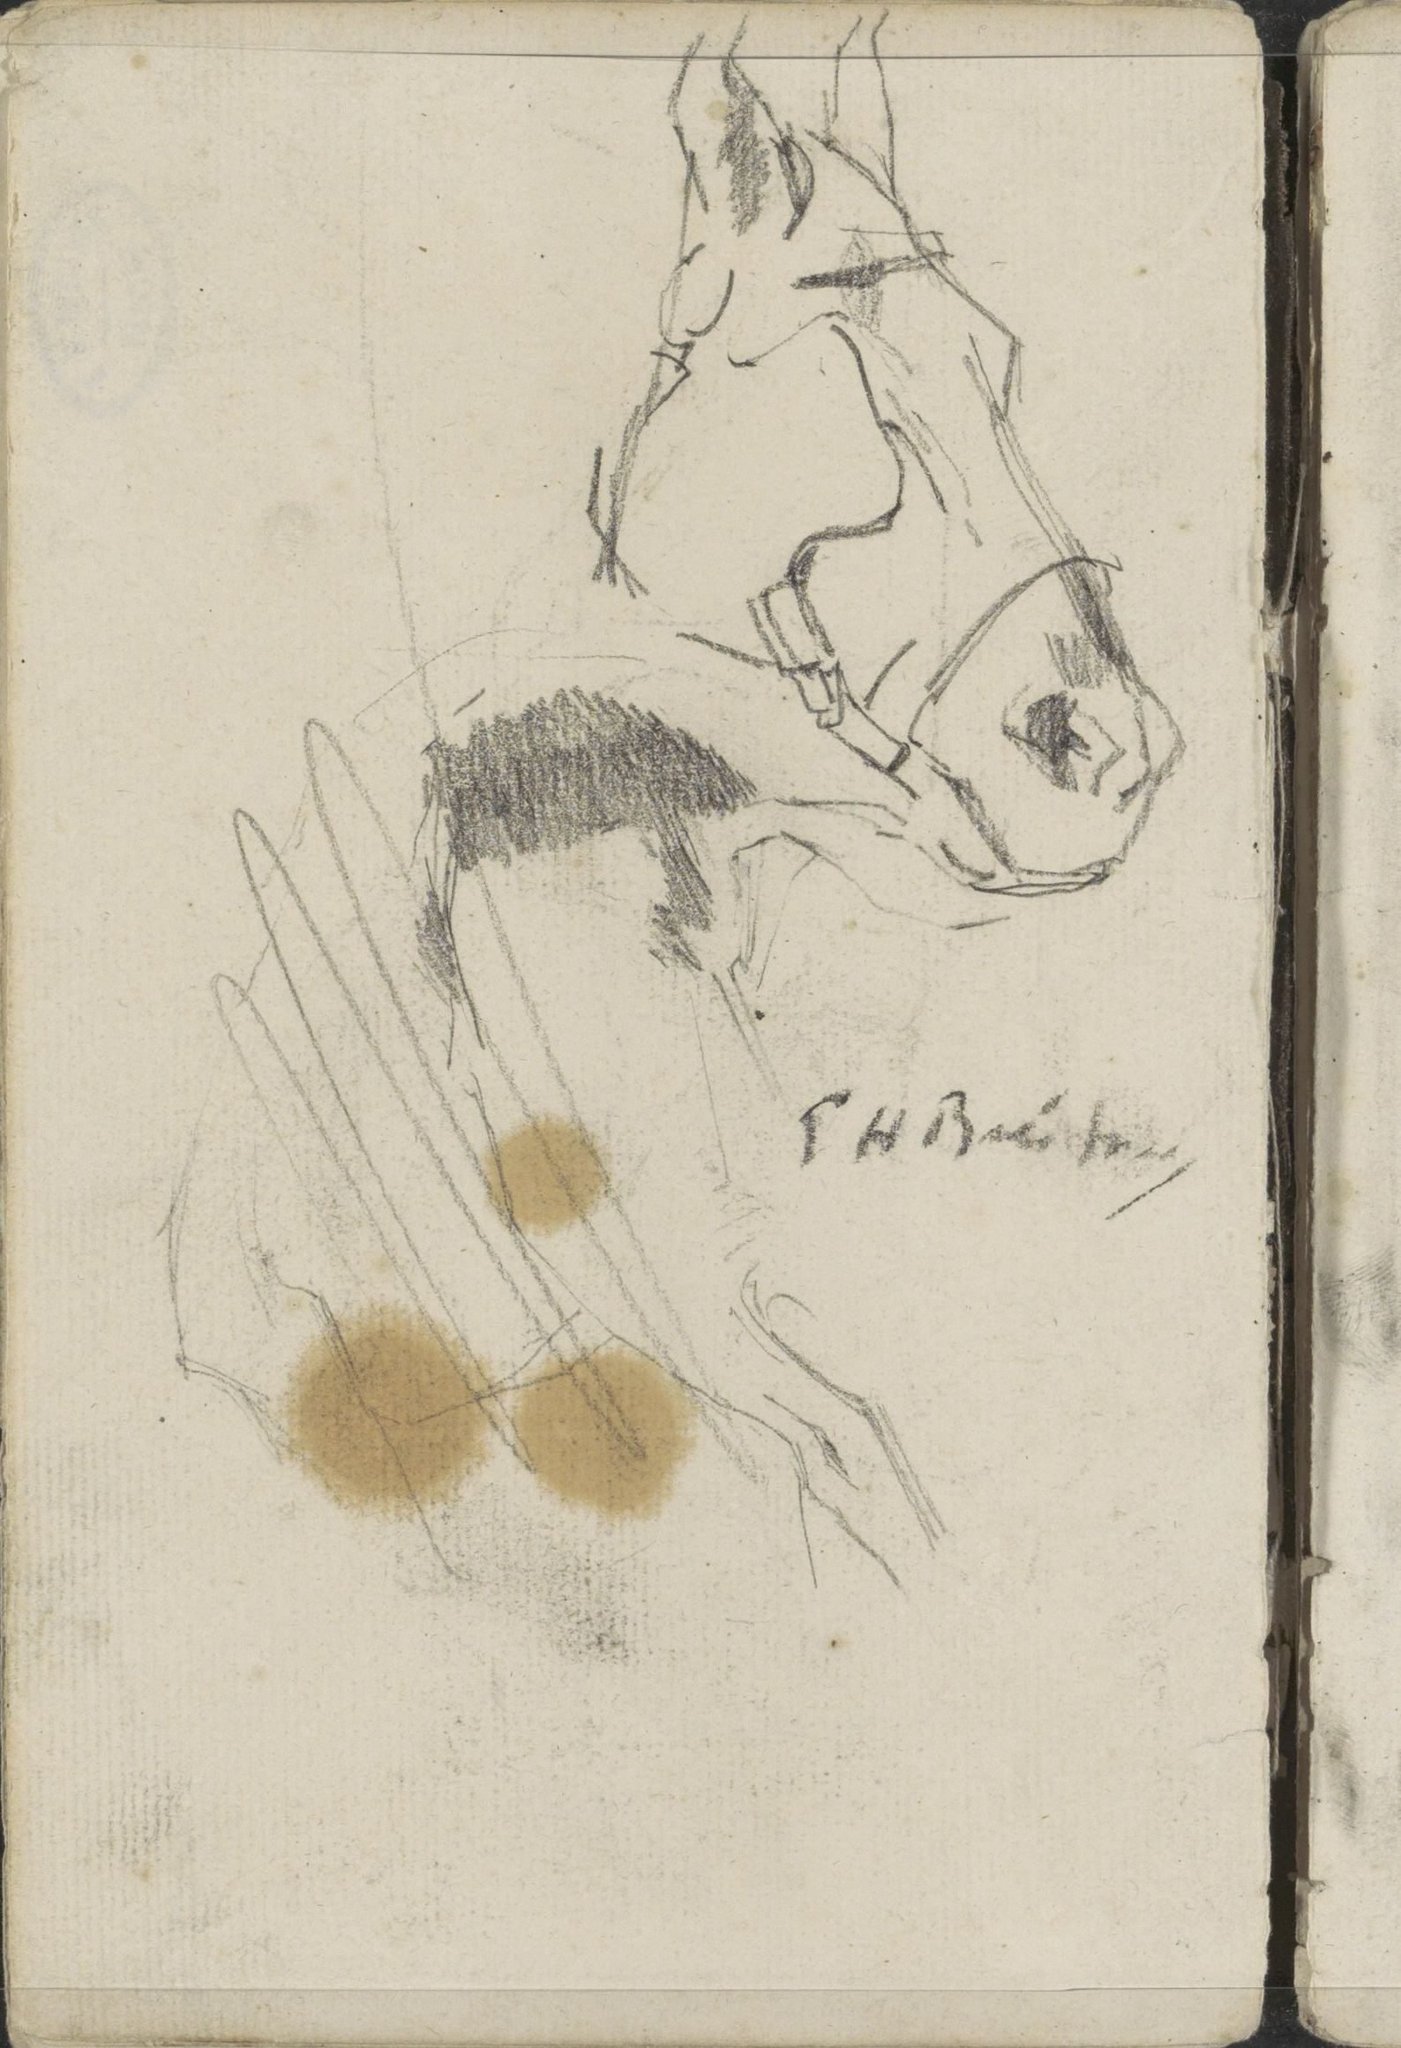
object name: sketchbook leaf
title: Paard met oogkleppen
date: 1880-1882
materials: chalk, paper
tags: horse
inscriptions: signature: ‘G H Breitner’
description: Blad 32 verso uit een schetsboek met 16 bladen.